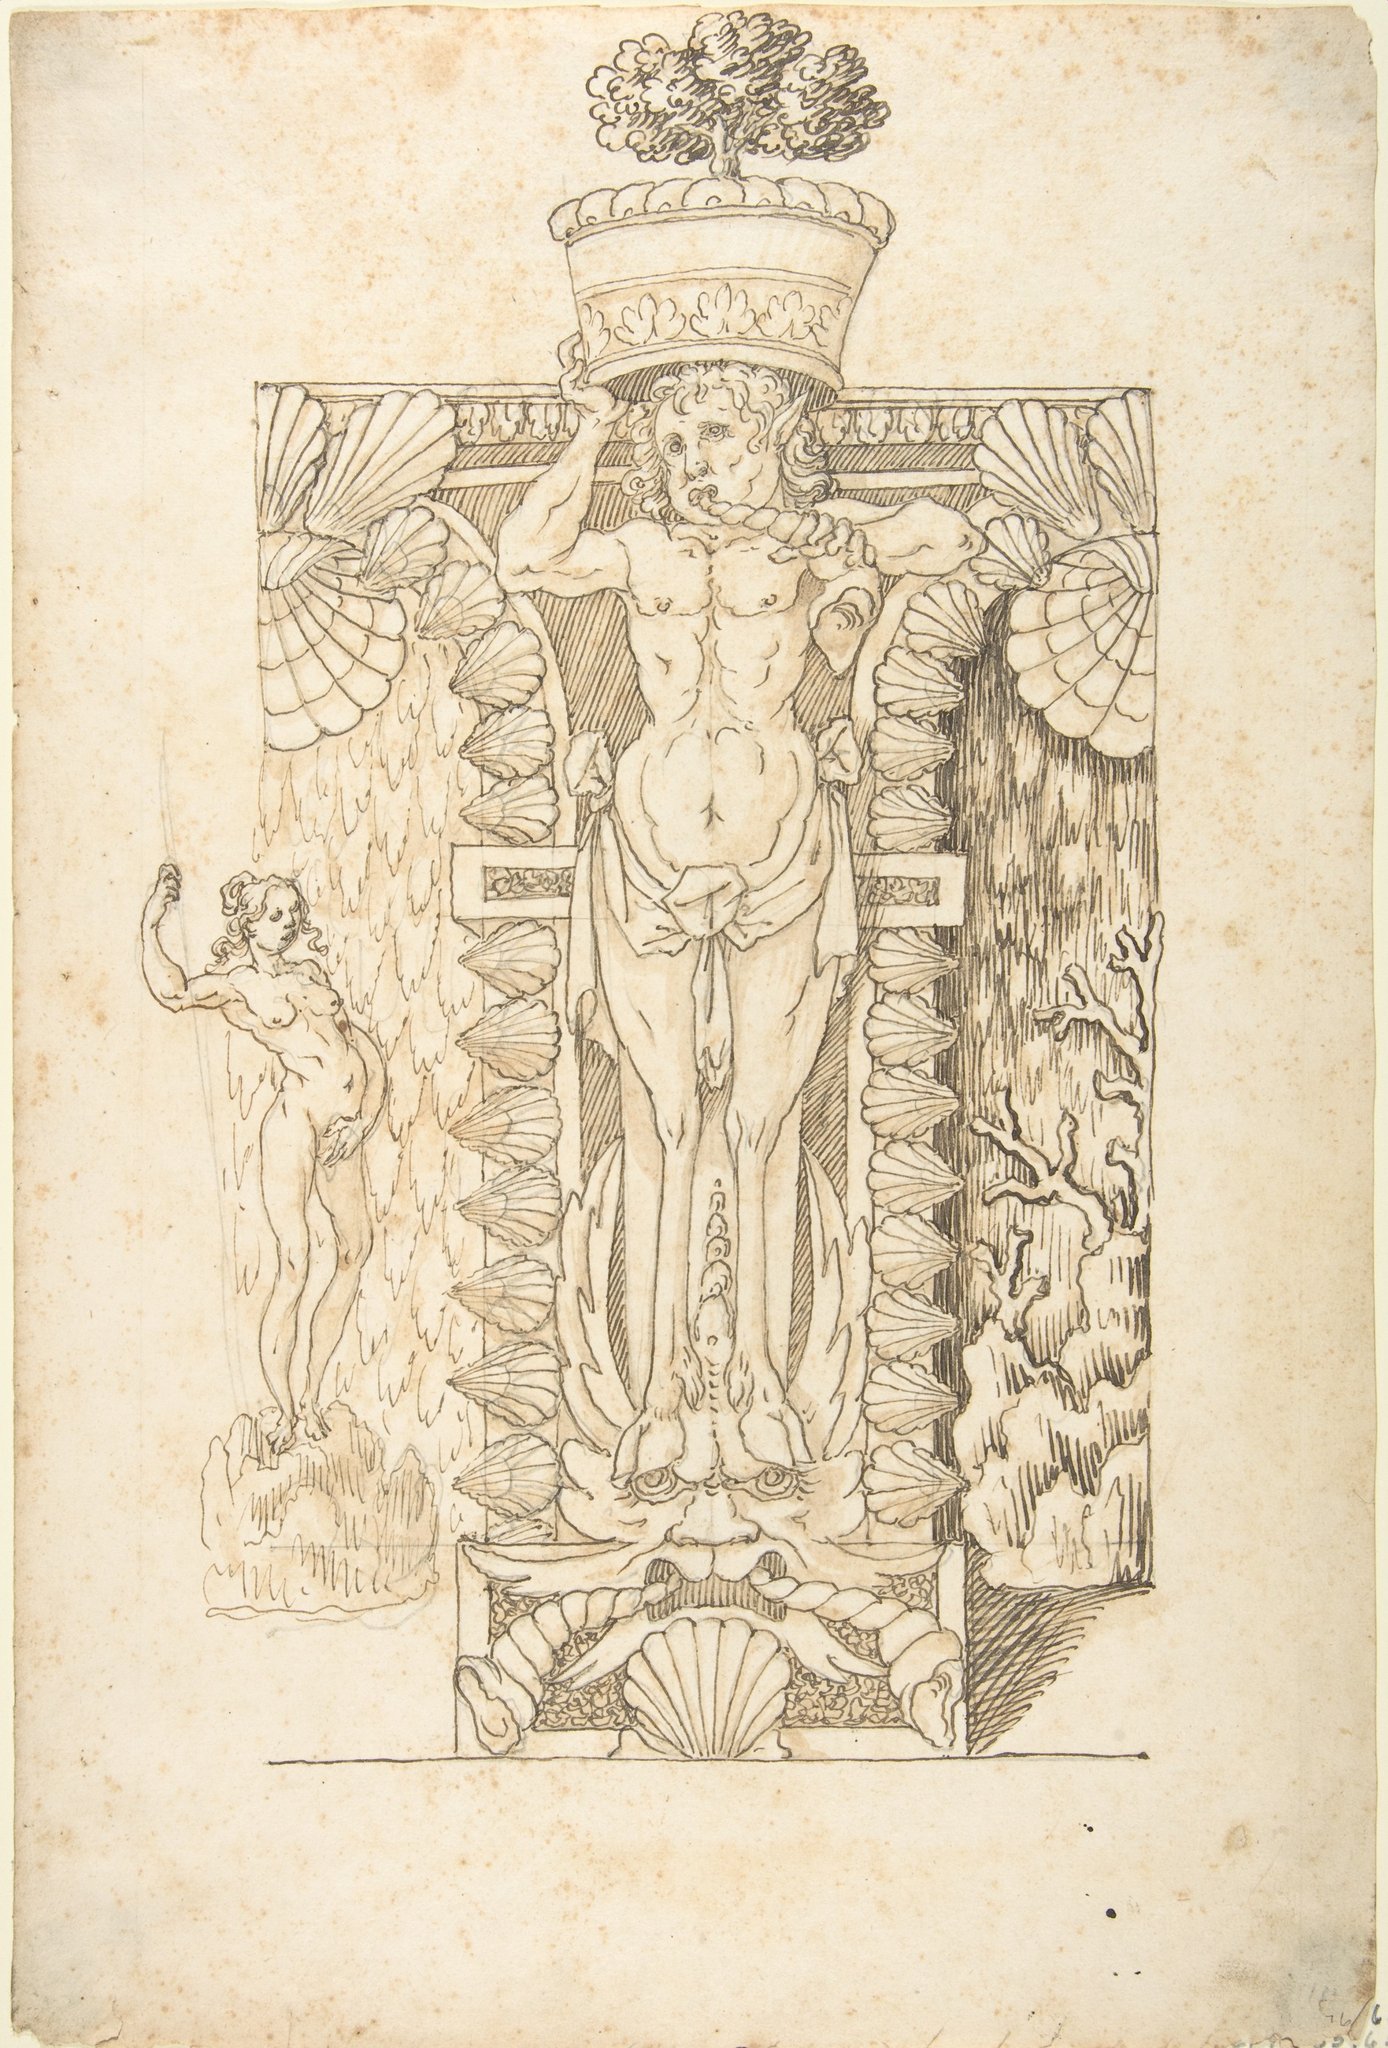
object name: drawing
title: Design for a Wall Fountain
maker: anonymous, italian, lombard, 16th century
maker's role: artist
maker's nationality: italian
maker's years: 1500-1600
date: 1550-1620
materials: ink, drawing material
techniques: pen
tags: fountains,palmettes,female nudes,satyrs